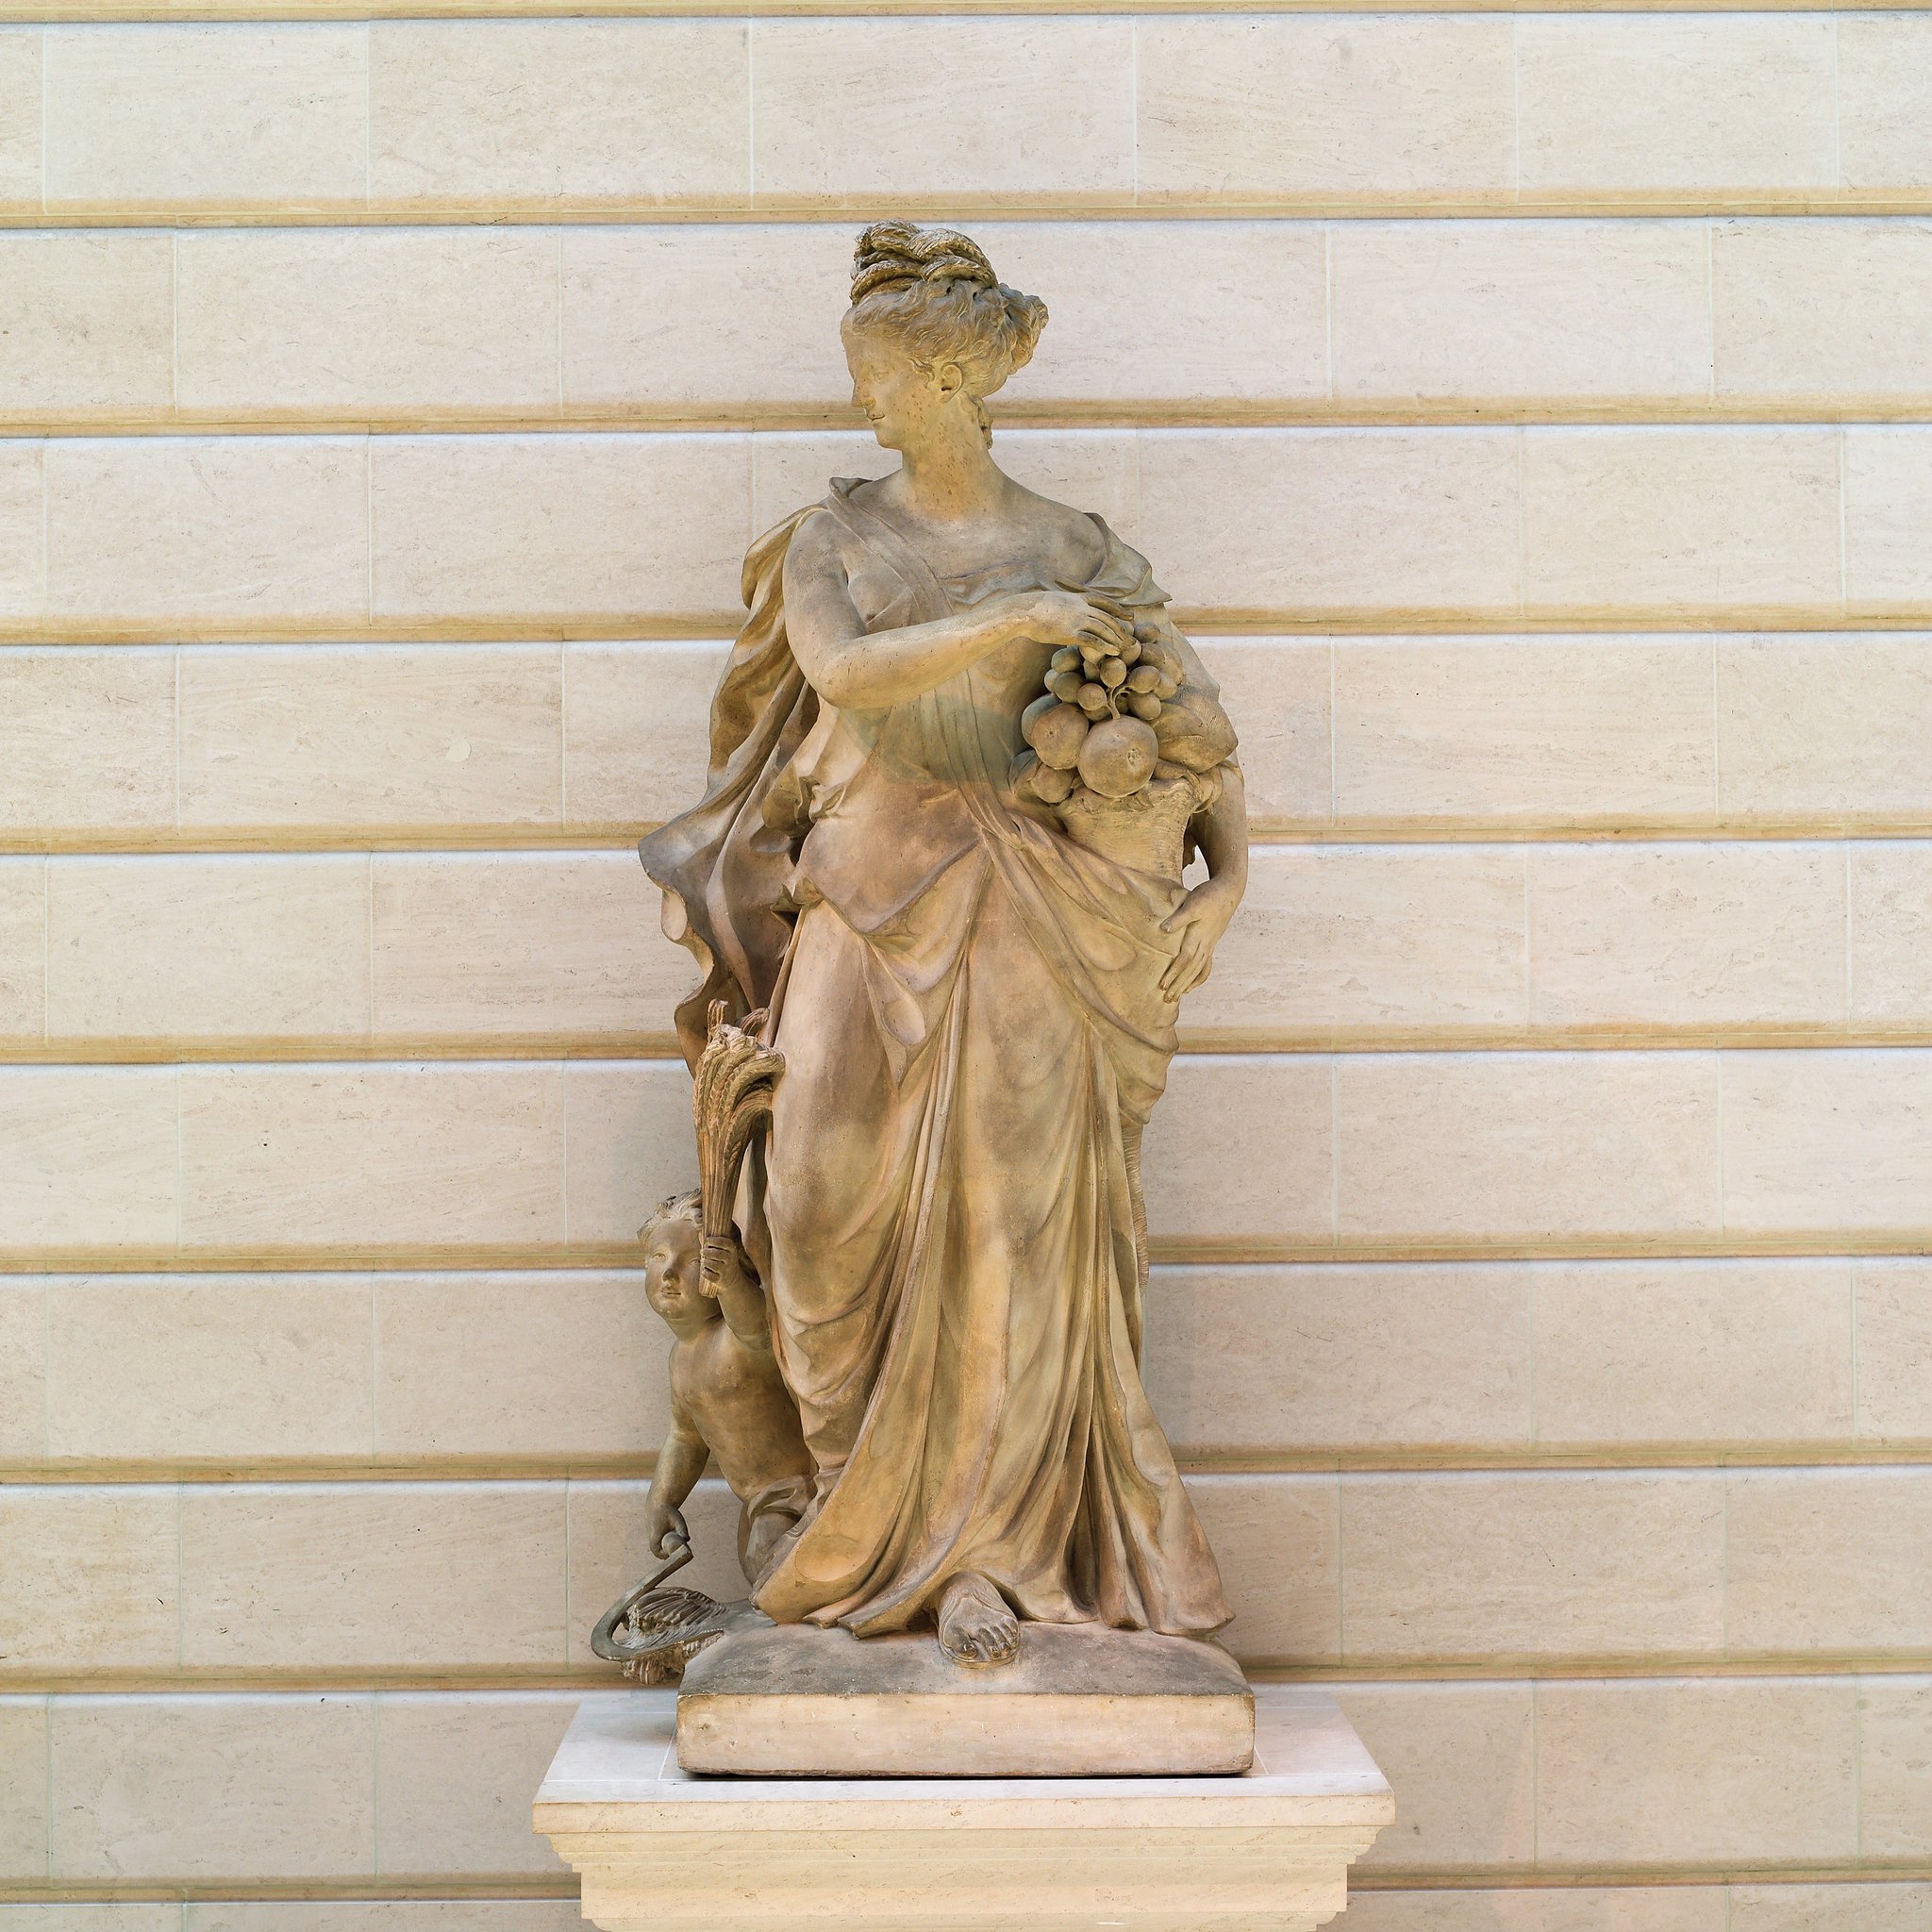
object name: statue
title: Earth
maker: jean-pierre defrance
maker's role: artist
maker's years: 1694-1768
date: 1750-1760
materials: limestone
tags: women,putti,cornucopia